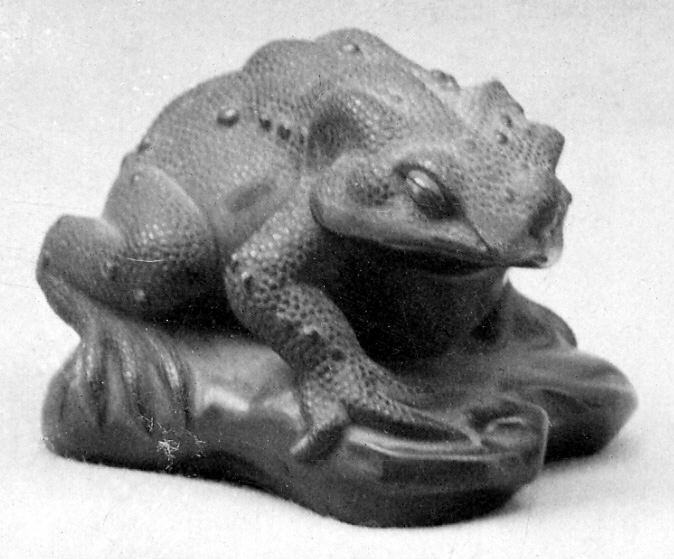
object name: paperweight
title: Toad Paperweight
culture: japanese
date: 1801-1900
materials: bronze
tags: frogs